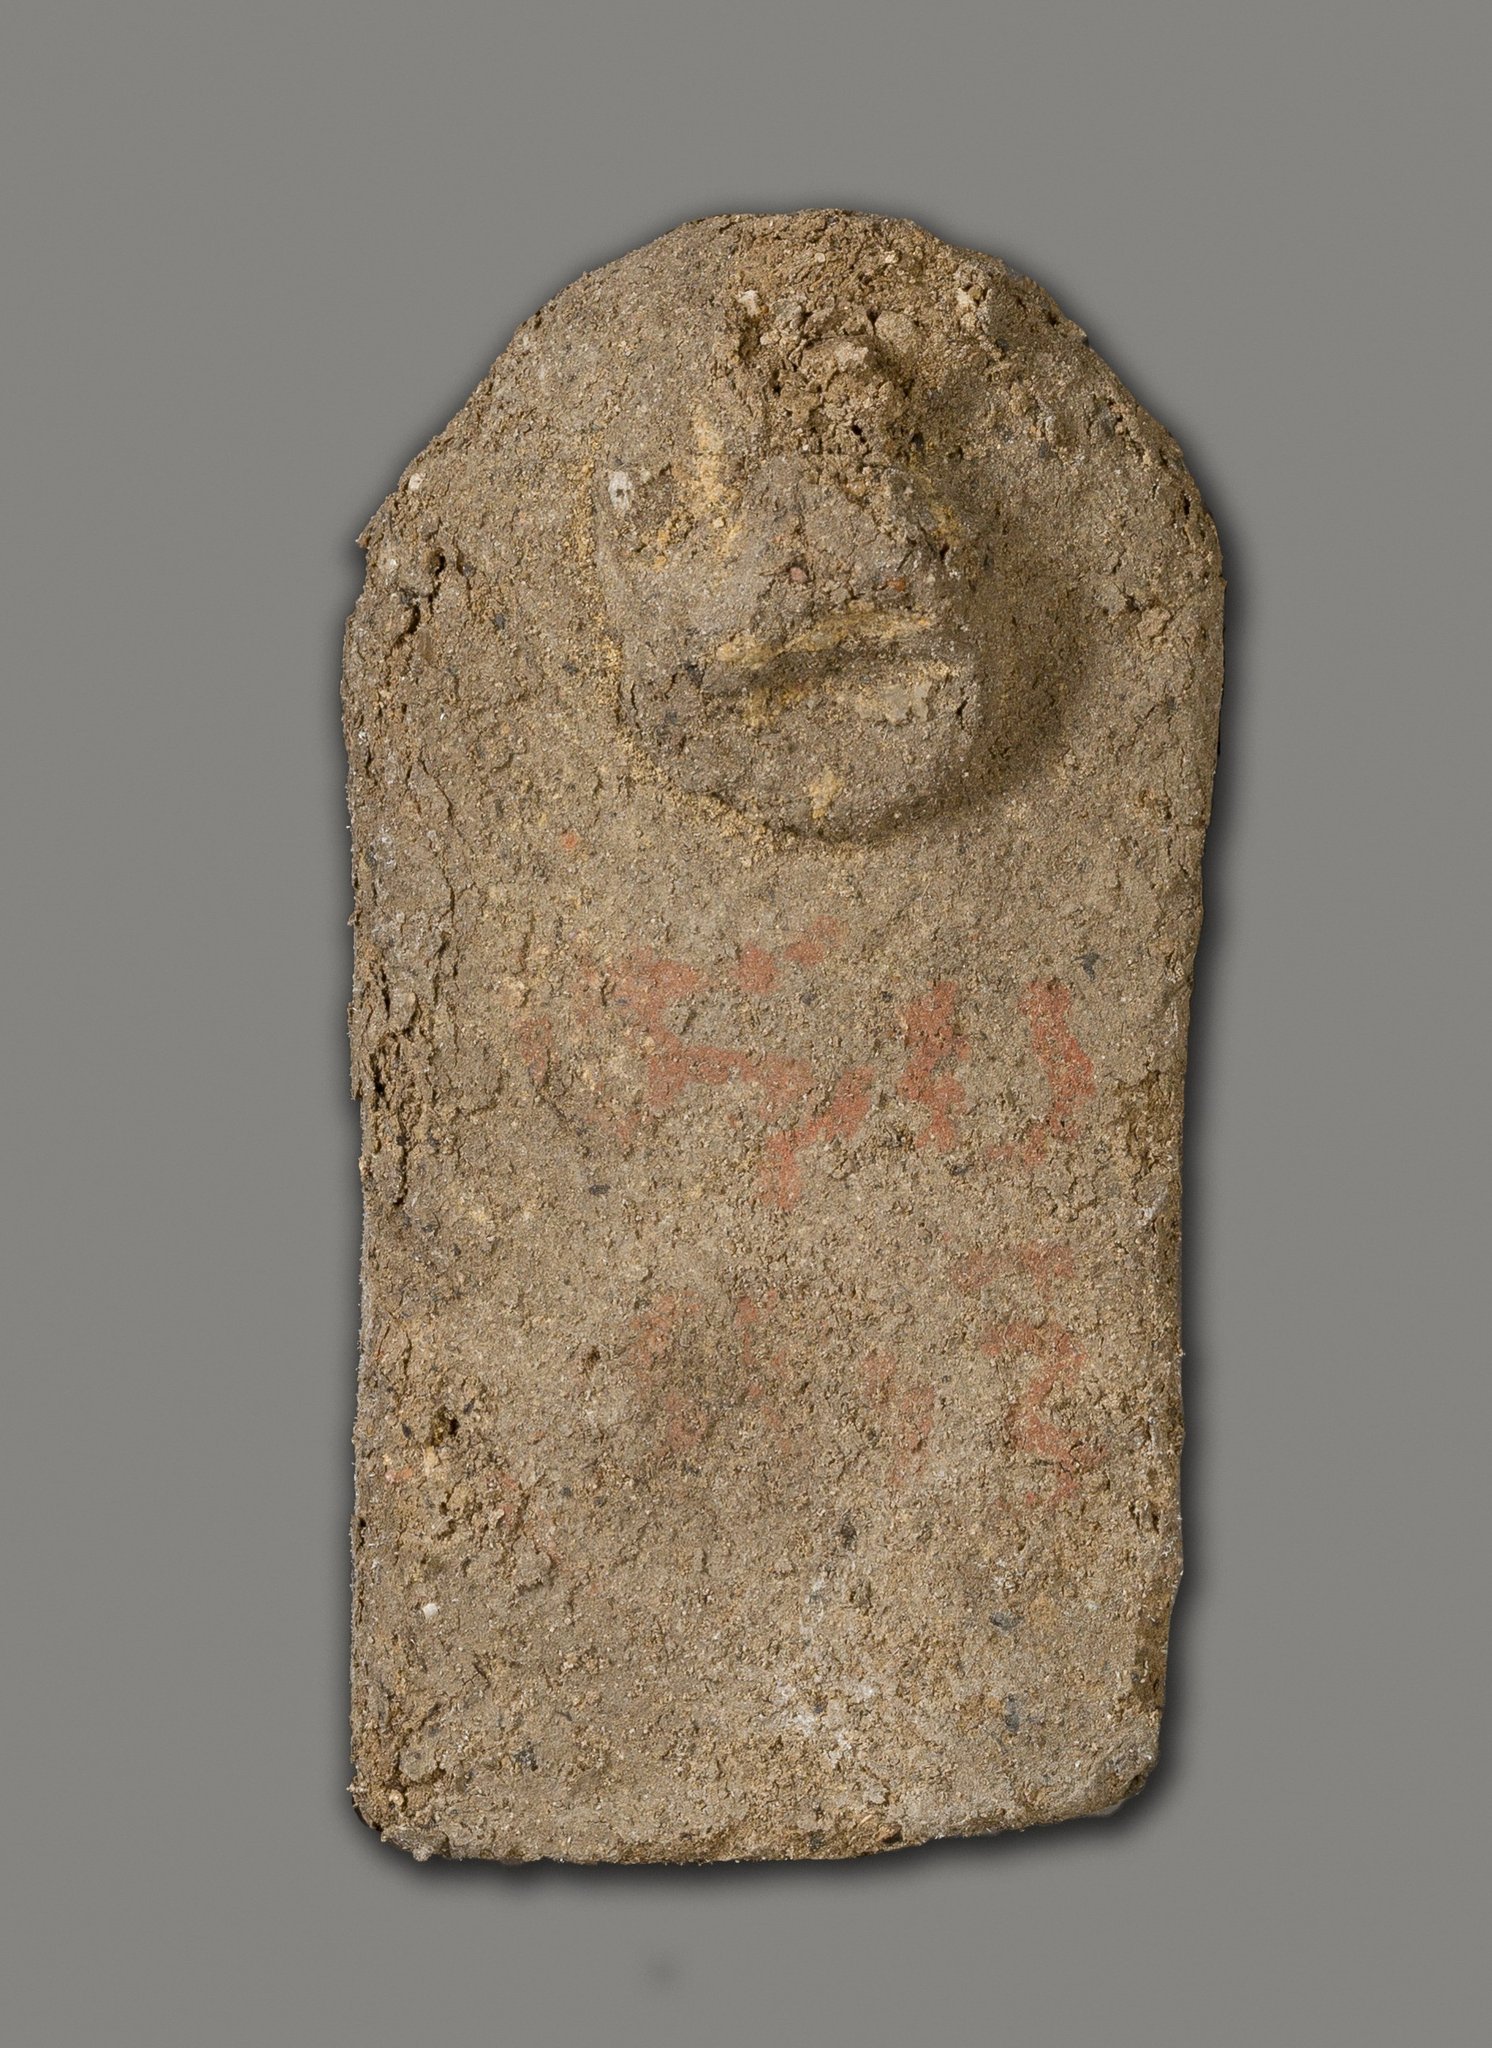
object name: figure, magical, execration, tablet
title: Magical Figure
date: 1802-1550 BCE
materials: clay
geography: egypt